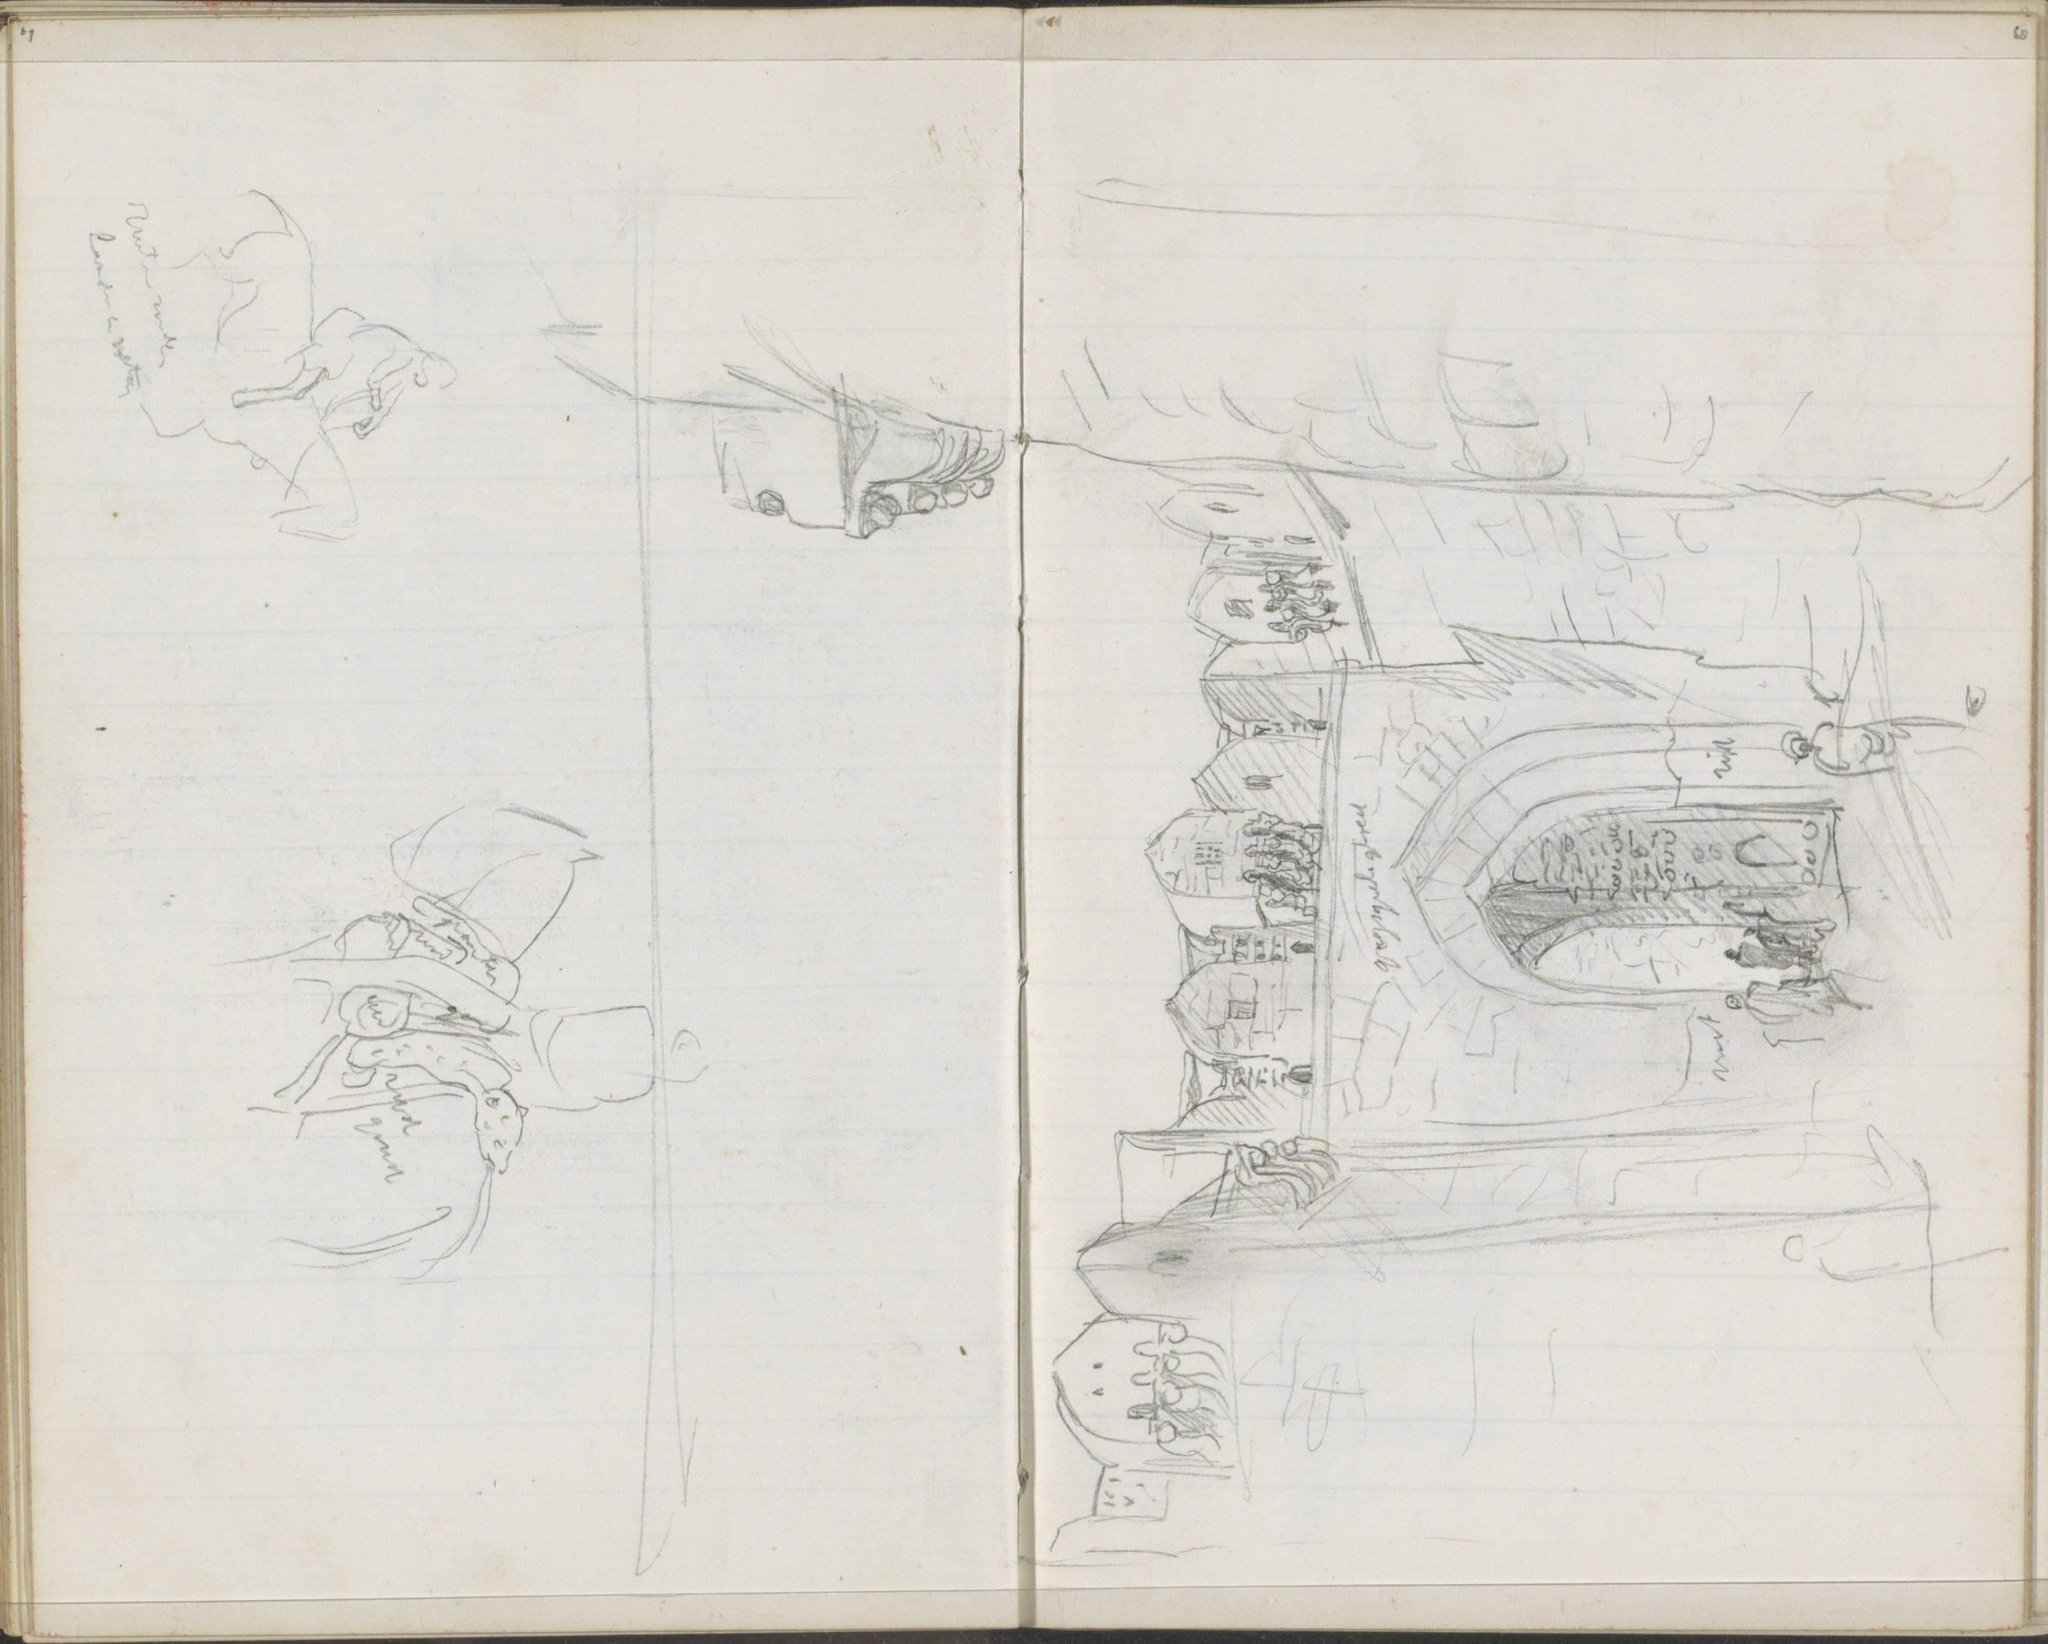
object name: sketchbook leaf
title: Figuren bij een stadspoort en ruiters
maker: marius bauer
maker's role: draughtsman, print maker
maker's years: 1867-1932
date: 1897-1898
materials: pencil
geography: india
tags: riding a horse, ass, or mule; rider, horseman, gate, entrance, street (+ city(-scape) with figures, staffage)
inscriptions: annotation: ‘ruiter zonder/ [...]and [...]’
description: Boven de poort zijn huizen van een stad te zien. Pagina 67 en 68 uit een schetsboek met 62 bladen.